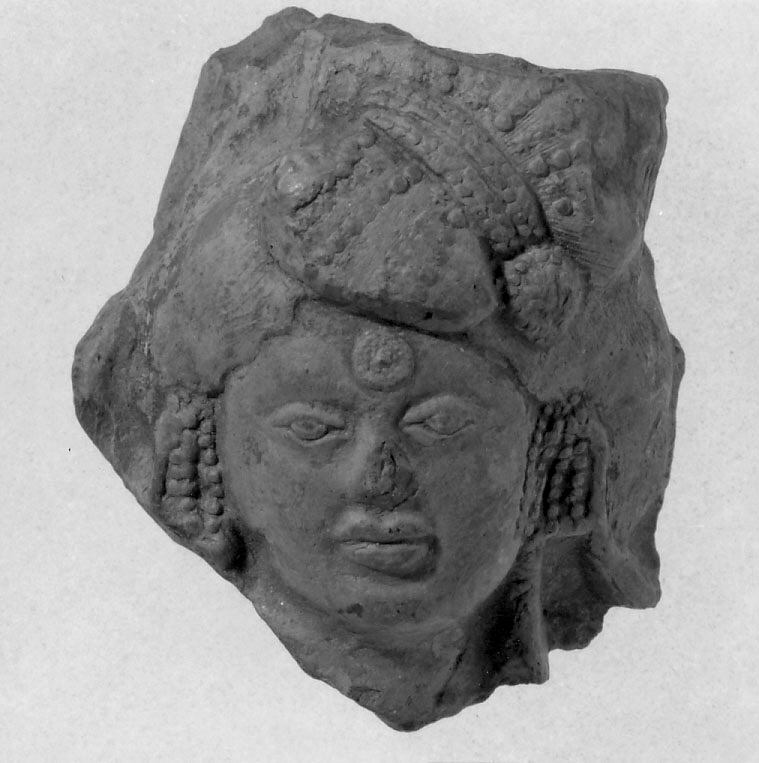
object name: toy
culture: indian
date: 100-1 BCE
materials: terracotta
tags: shunga,heads,women